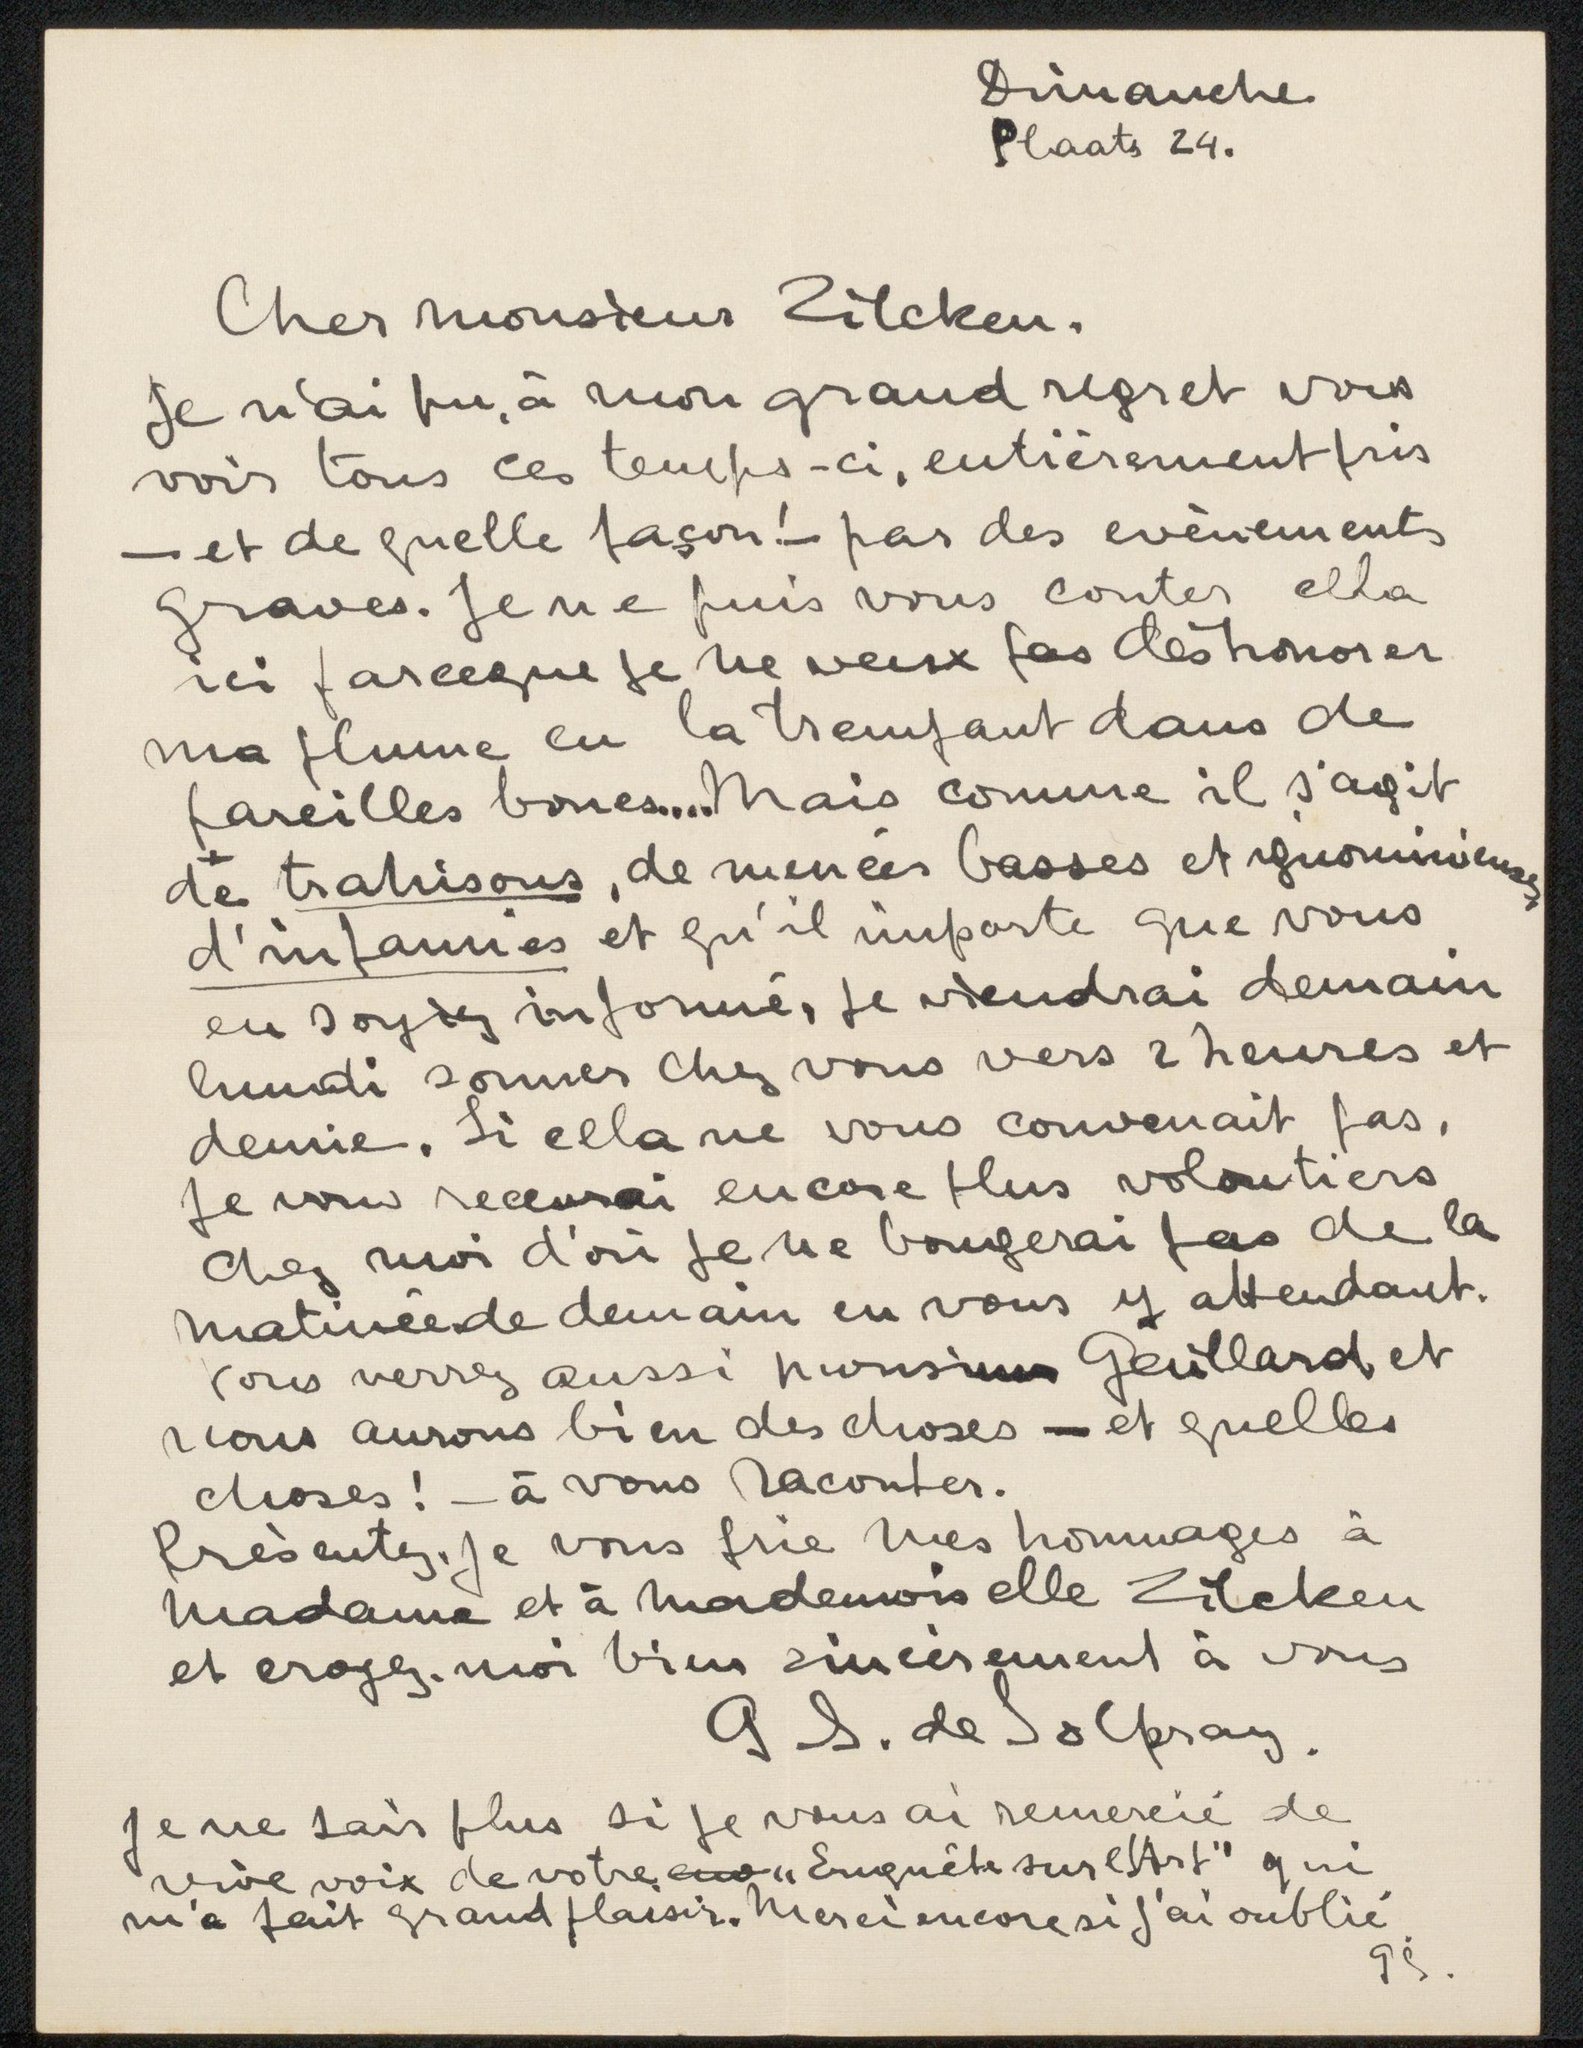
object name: letter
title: Brief aan Philip Zilcken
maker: georges de solpray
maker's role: schrijver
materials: ink, paper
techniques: pen, writing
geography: the hague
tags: the hague, painter, draughtsman, philip zilcken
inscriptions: collector's mark: ‘RPK’